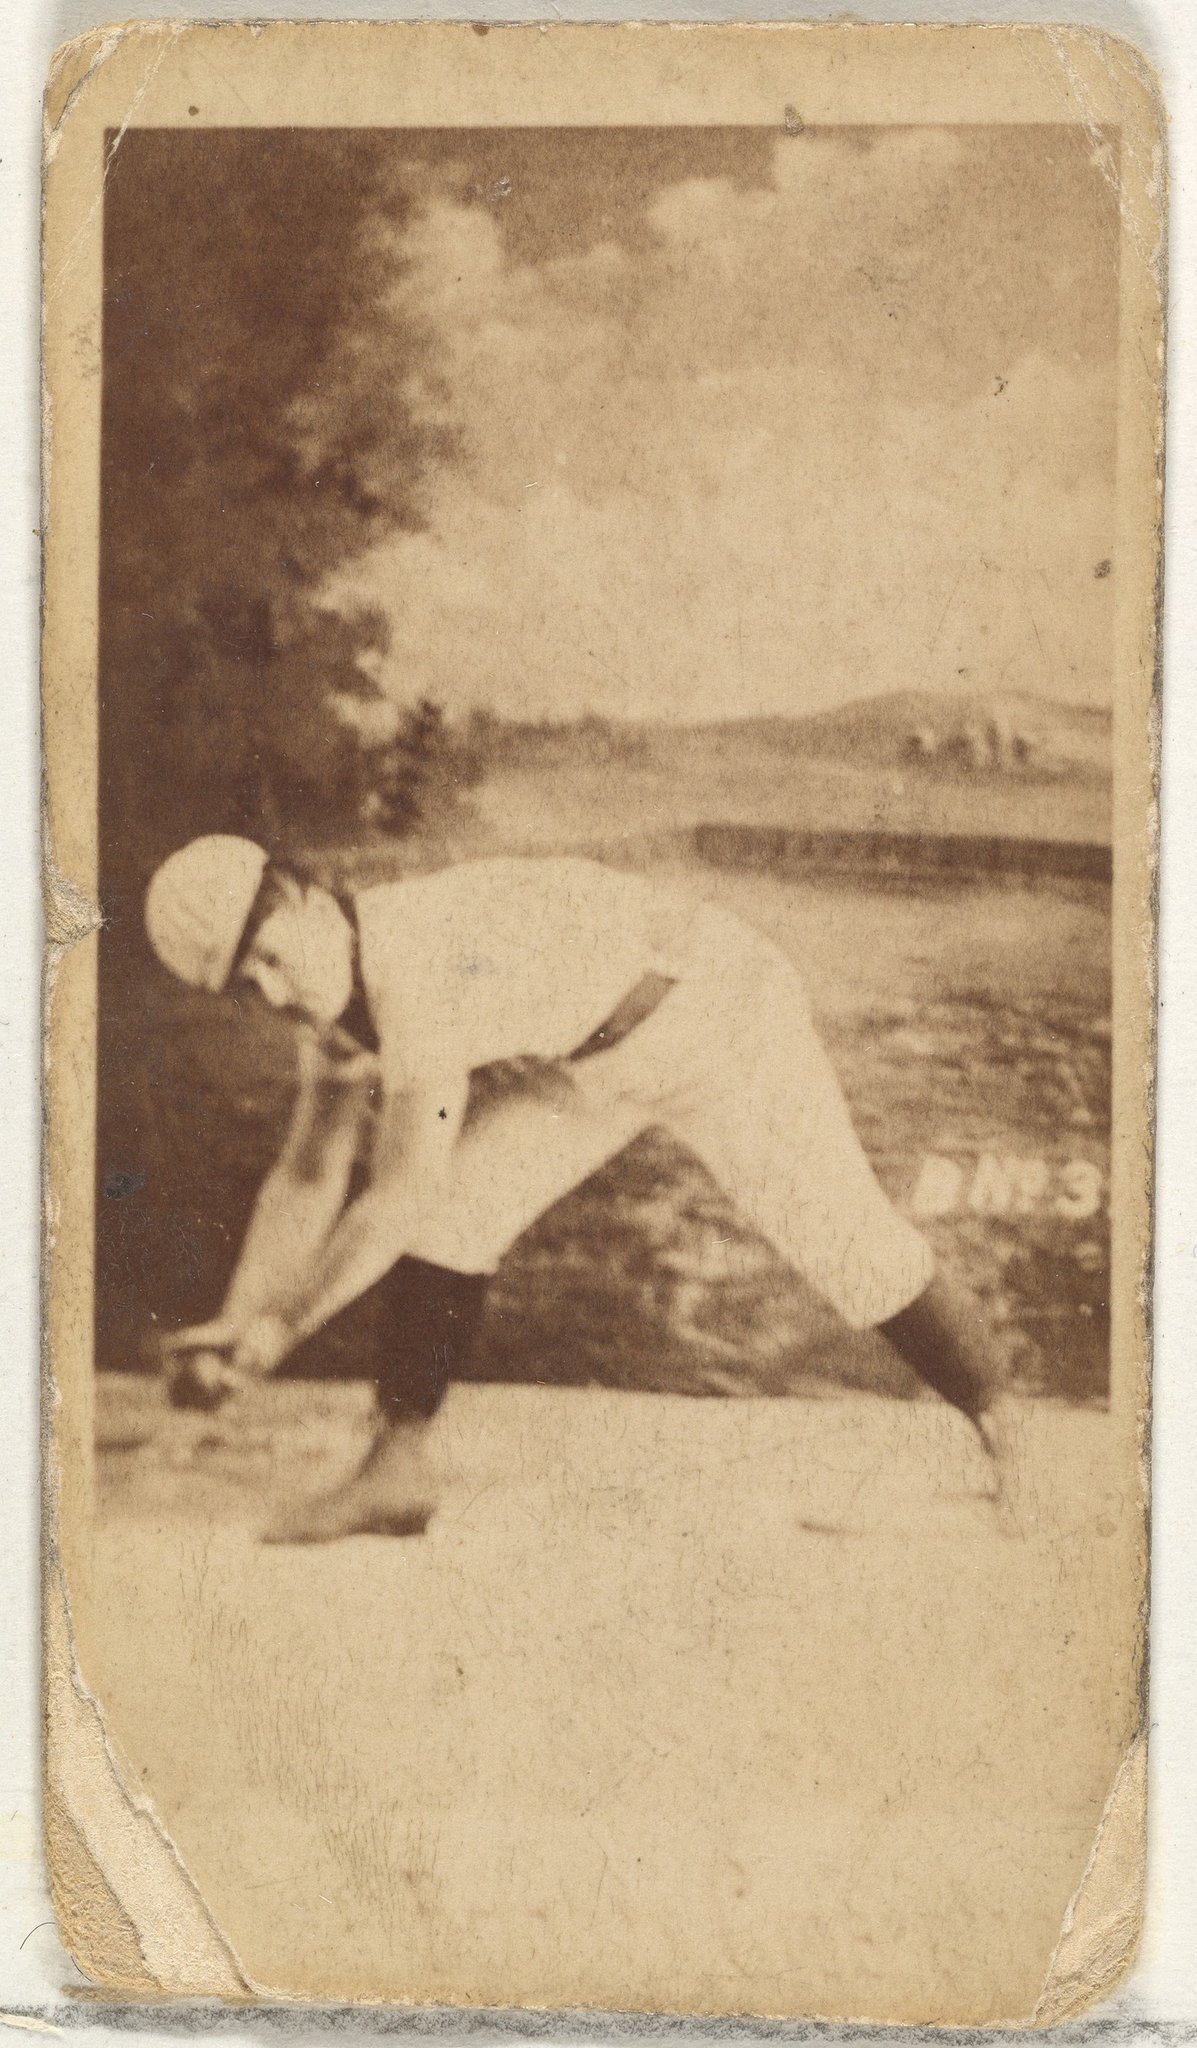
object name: baseball card, photograph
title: Card 3, from the Girl Baseball Players series (N48, Type 1) for Virginia Brights Cigarettes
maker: allen & ginter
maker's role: publisher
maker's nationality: american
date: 1886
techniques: albumen silver print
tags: portraits,women,baseball,athletes